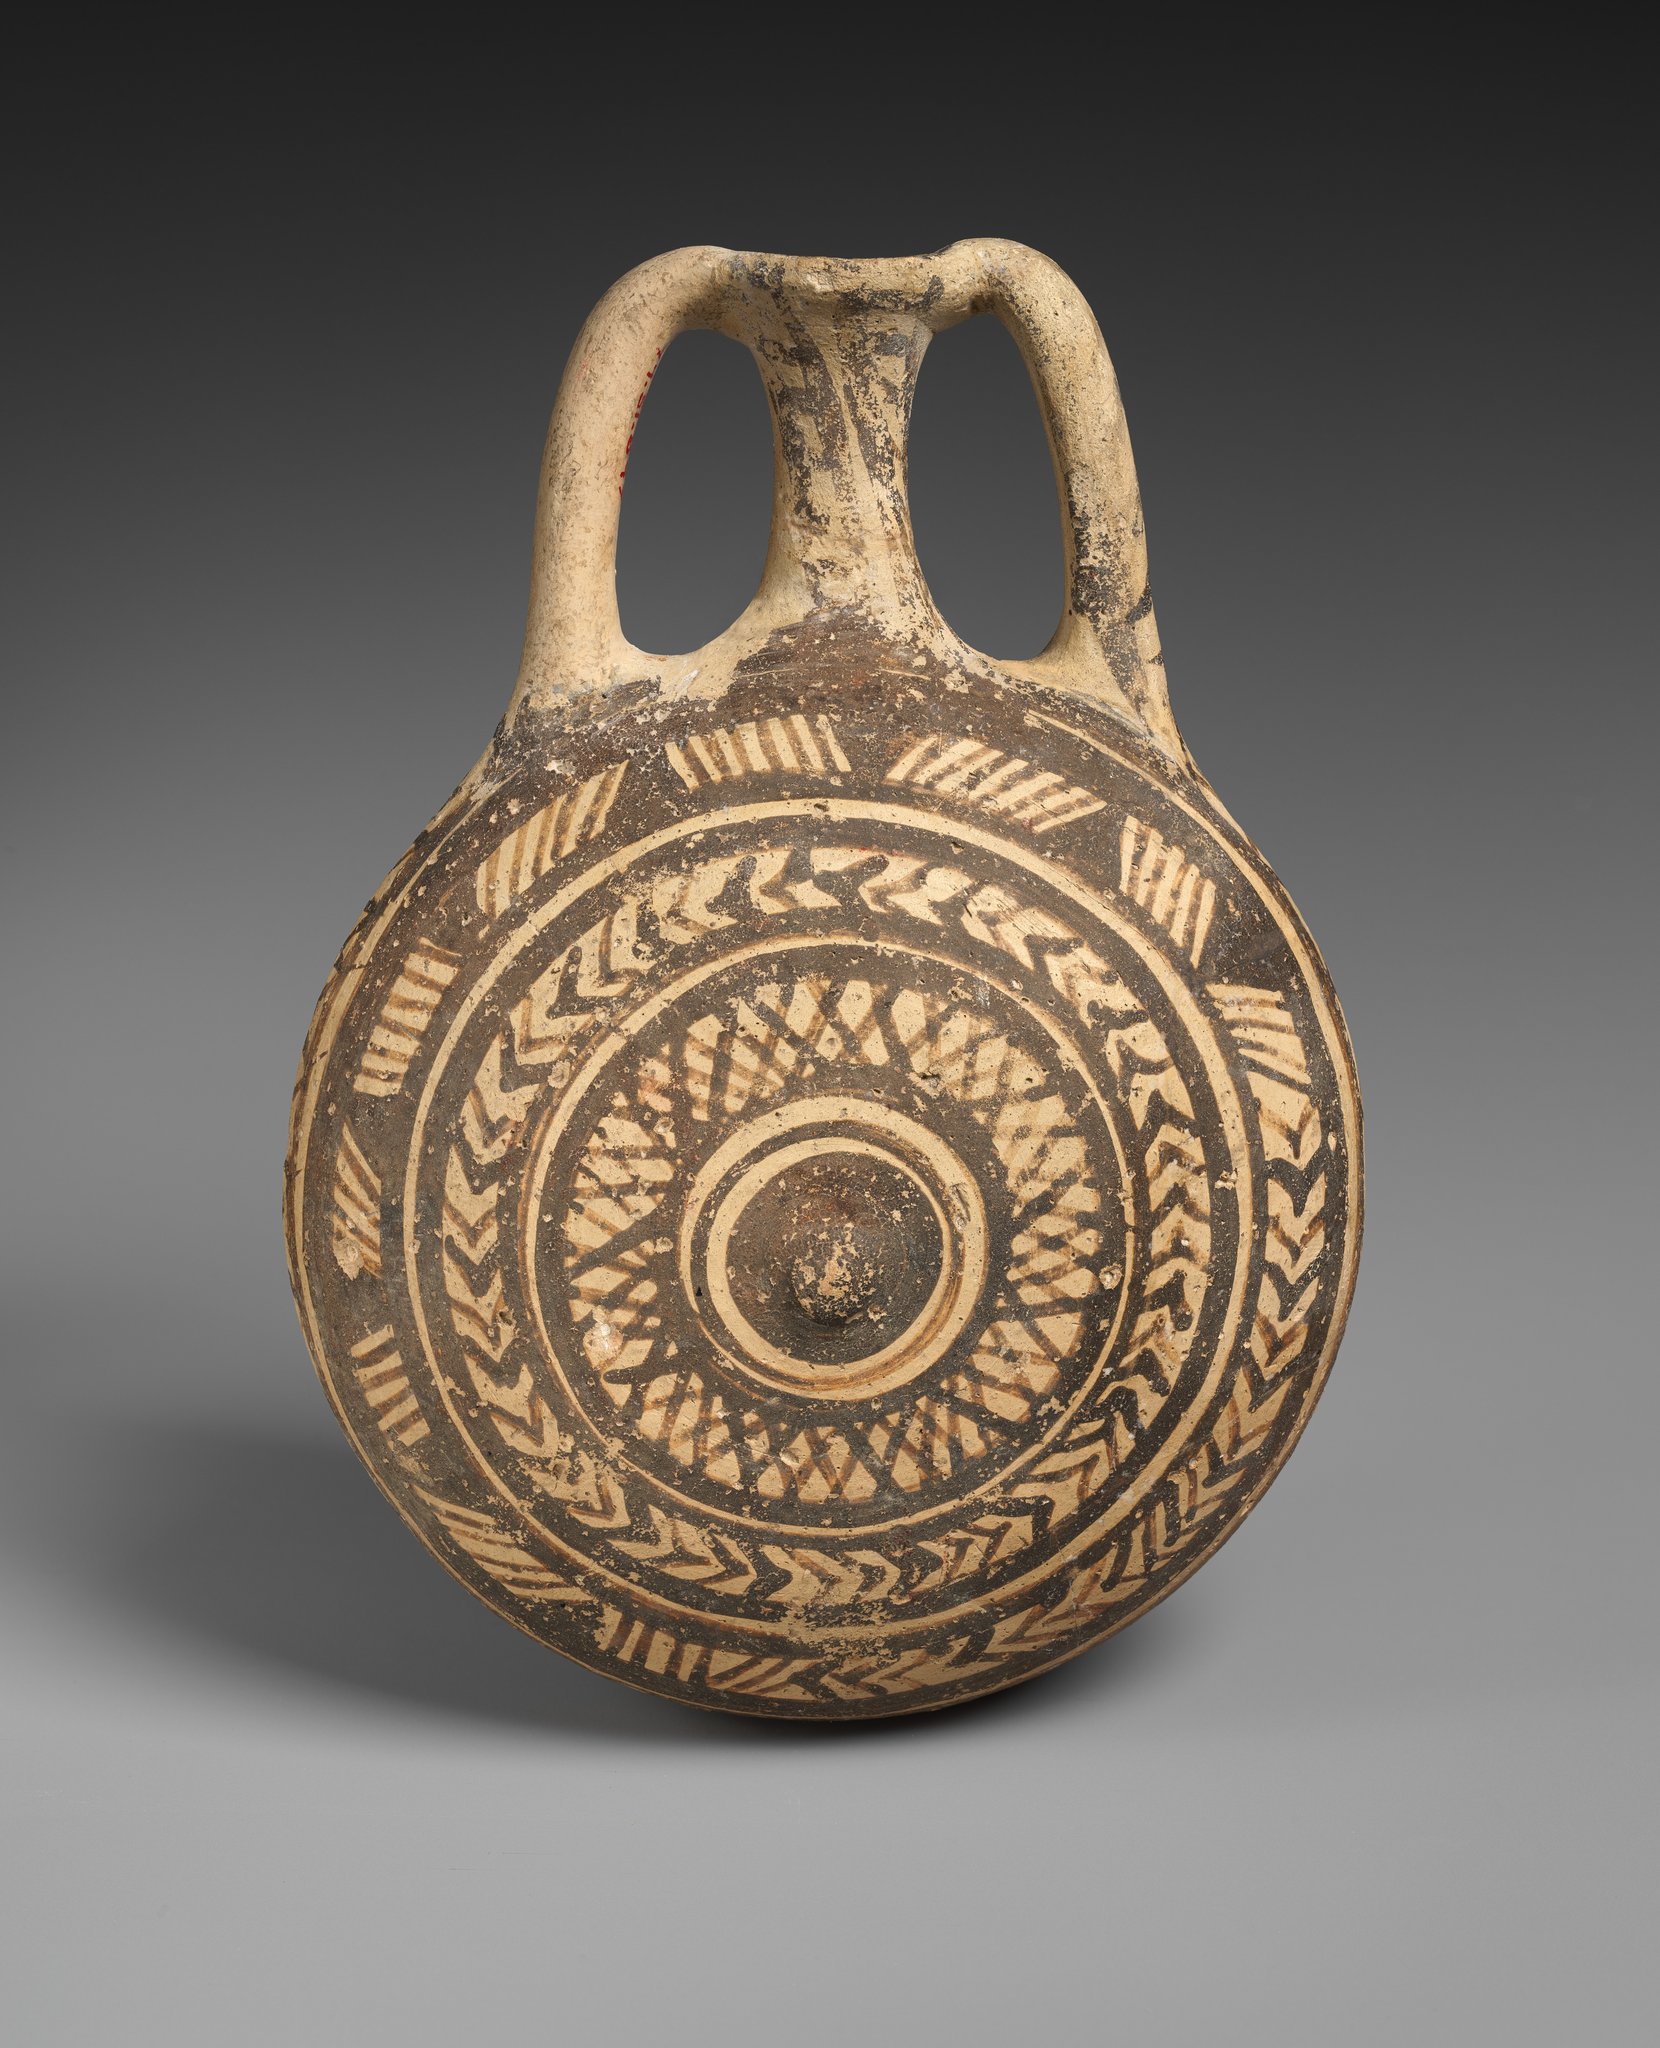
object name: flask, lentoid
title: Terracotta lentoid flask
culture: cypriot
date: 1200-1050 BCE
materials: terracotta